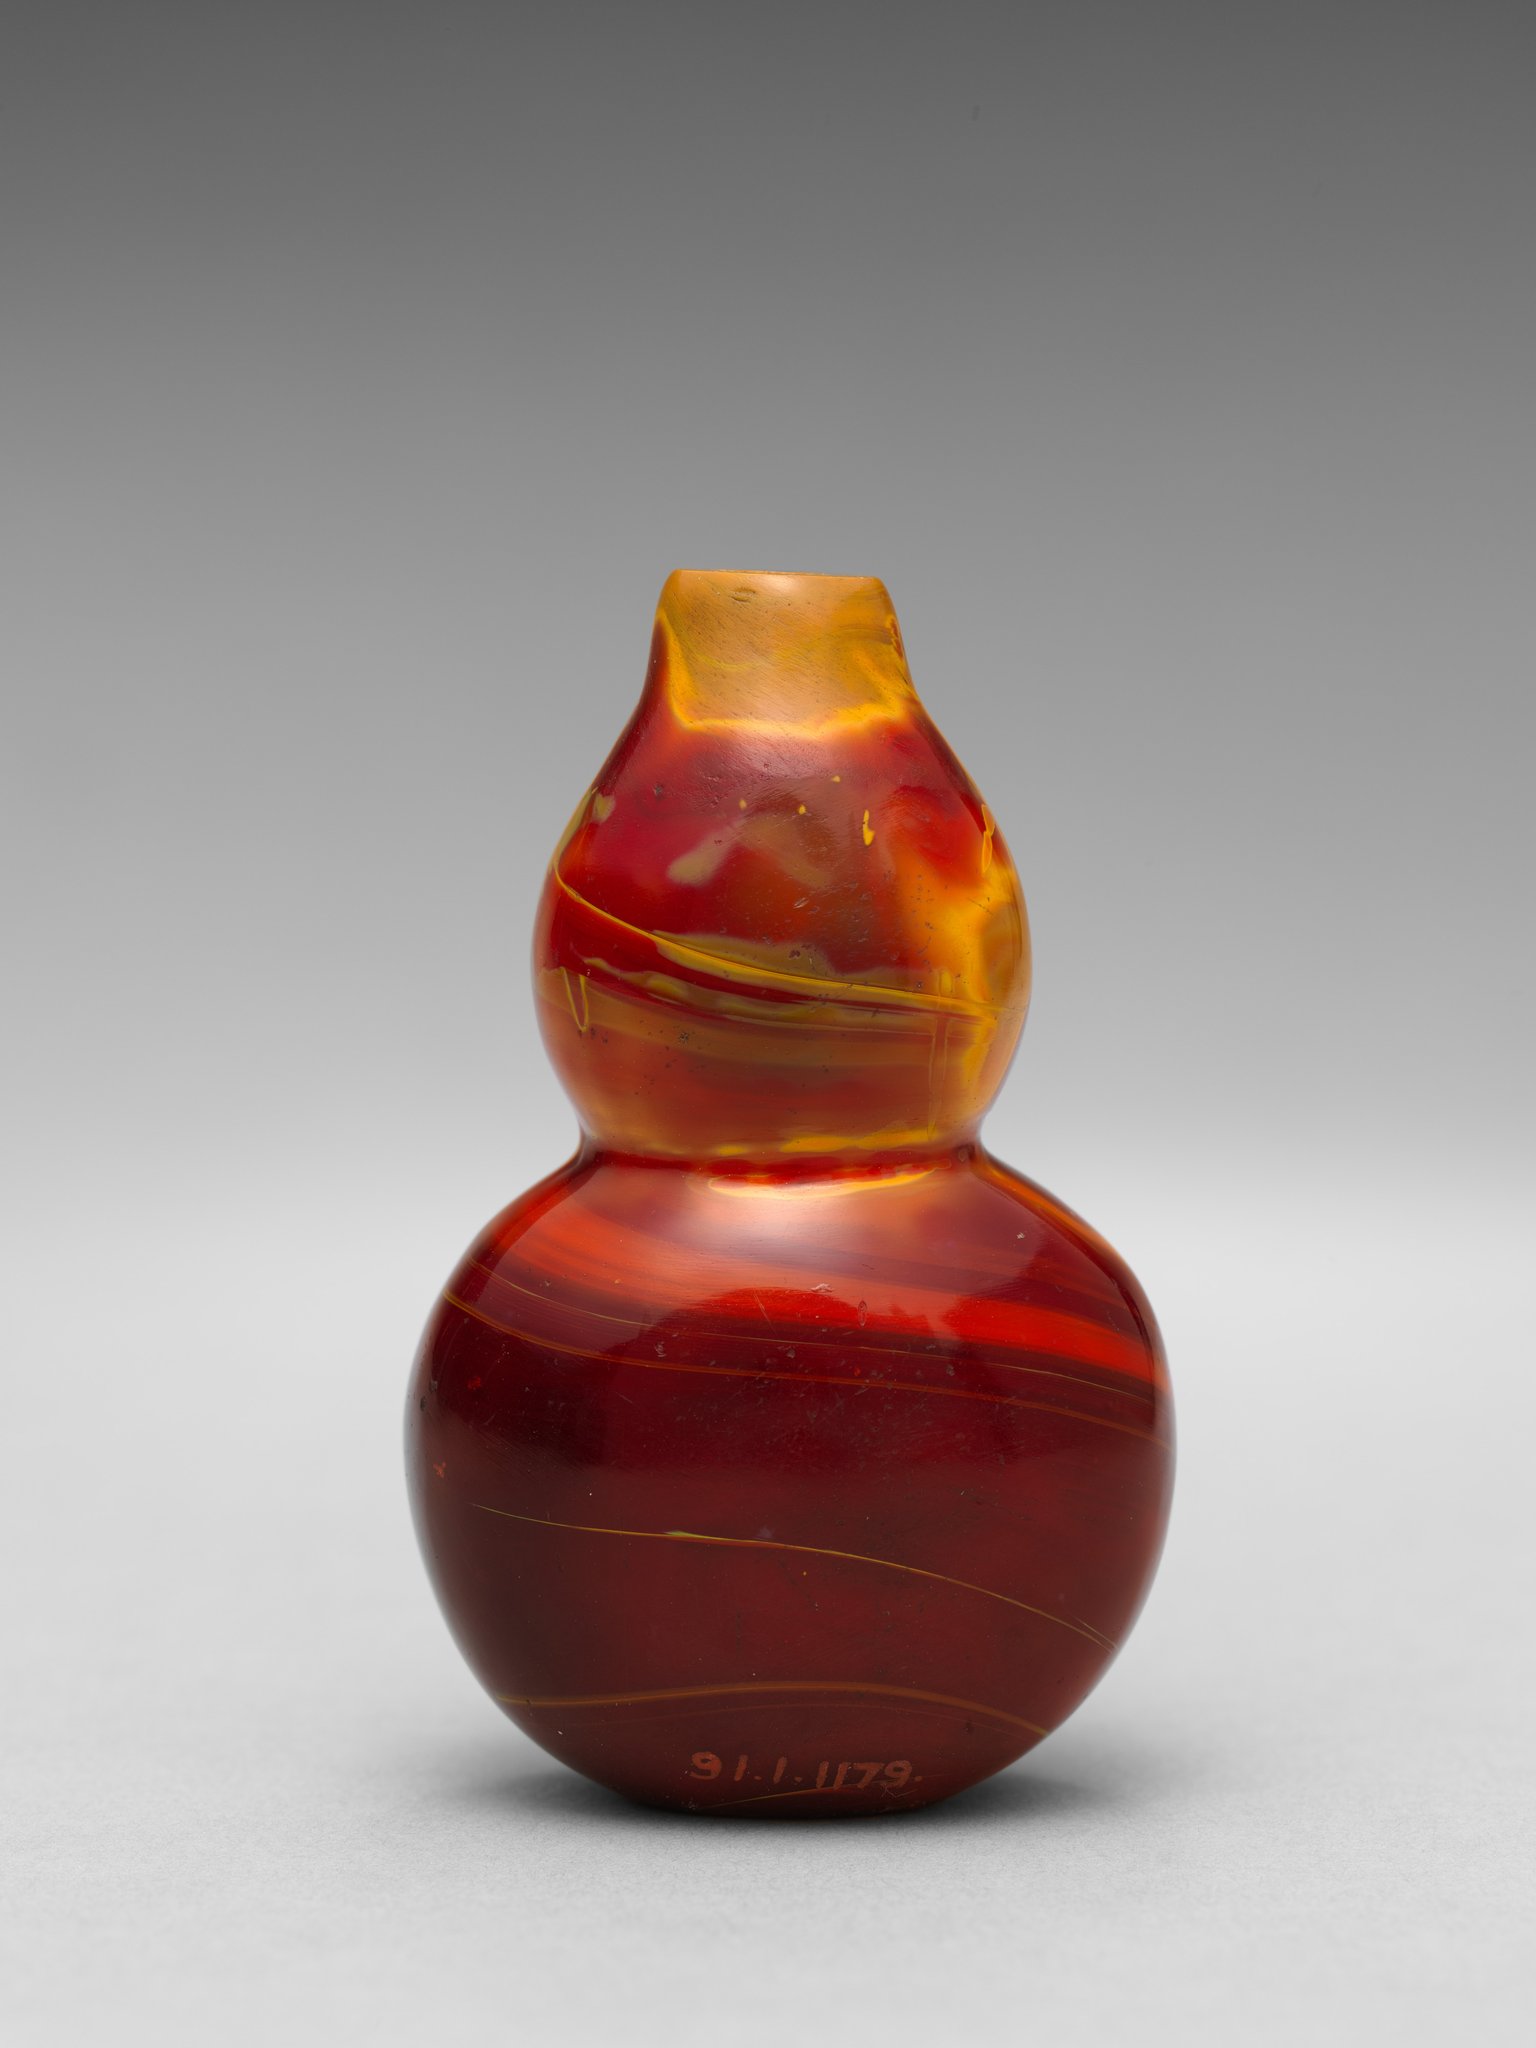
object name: snuff bottle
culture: chinese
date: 1736-1795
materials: glass